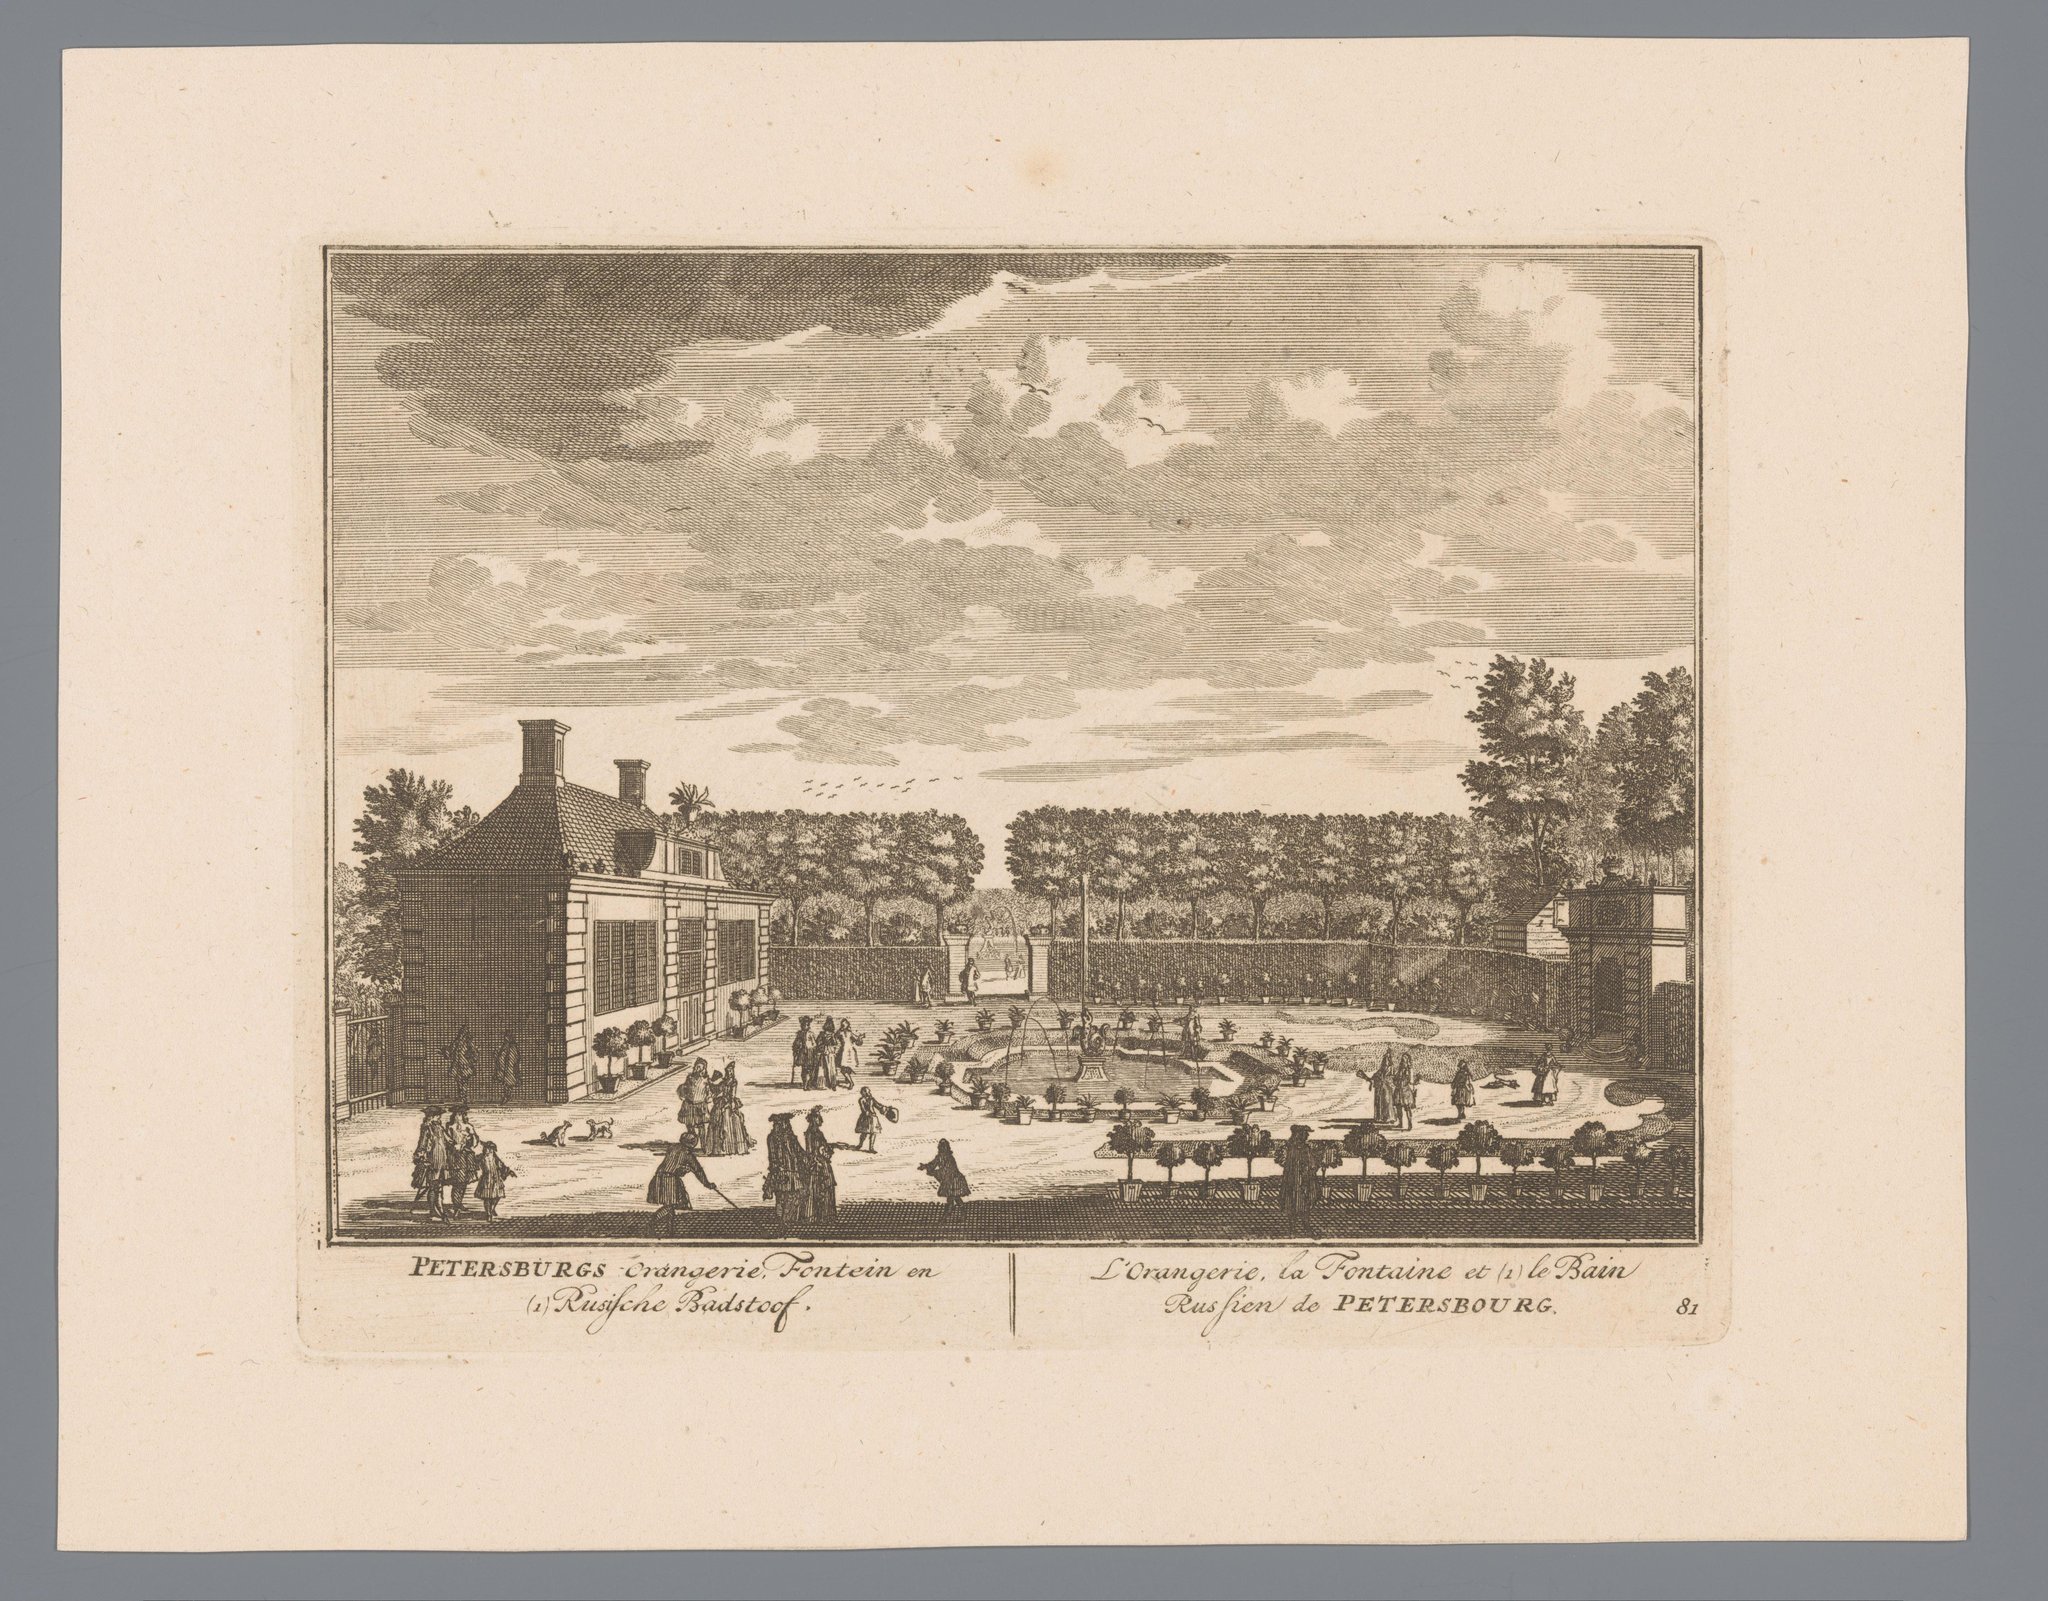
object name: print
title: Petersburgs Orangerie, Fontein en (1) Rusische Badstoof / L'Orangerie, la Fontaine et (1) le Bain Russien de Petersbourg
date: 1719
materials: paper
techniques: engraving, etching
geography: amsterdam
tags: garden fountain, rural housing, e.g. country-house, villa, cottage, french or architectonic garden; formal garden, greenhouse, orangery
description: Prent uit: De zegepraalende Vecht, vertoonende verscheidene gesichten van lustplaatsen, heeren huysen en dorpen, beginnende van Uitrecht en met Muyden besluytende. Amsterdam: Wed. Nicolaes Visscher, 1719.